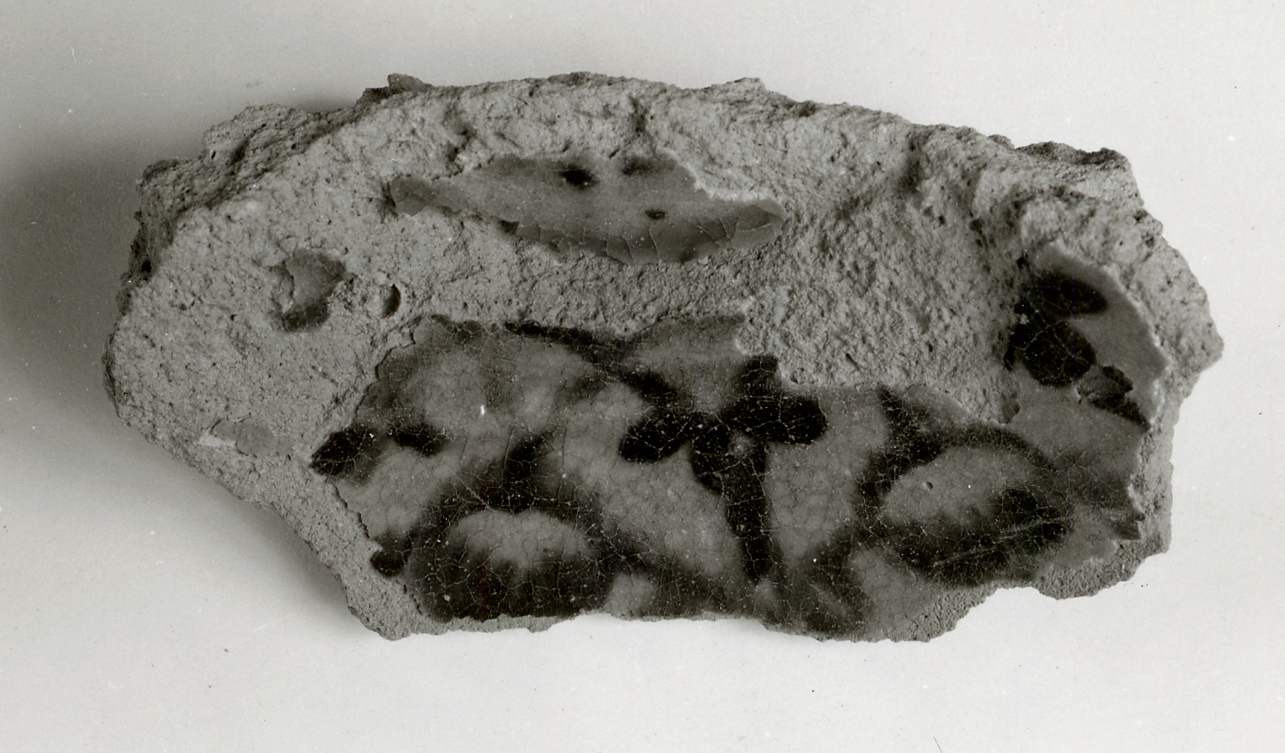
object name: fragment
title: Vessel Fragment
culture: coptic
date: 301-700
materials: earthenware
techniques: glazing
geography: egypt